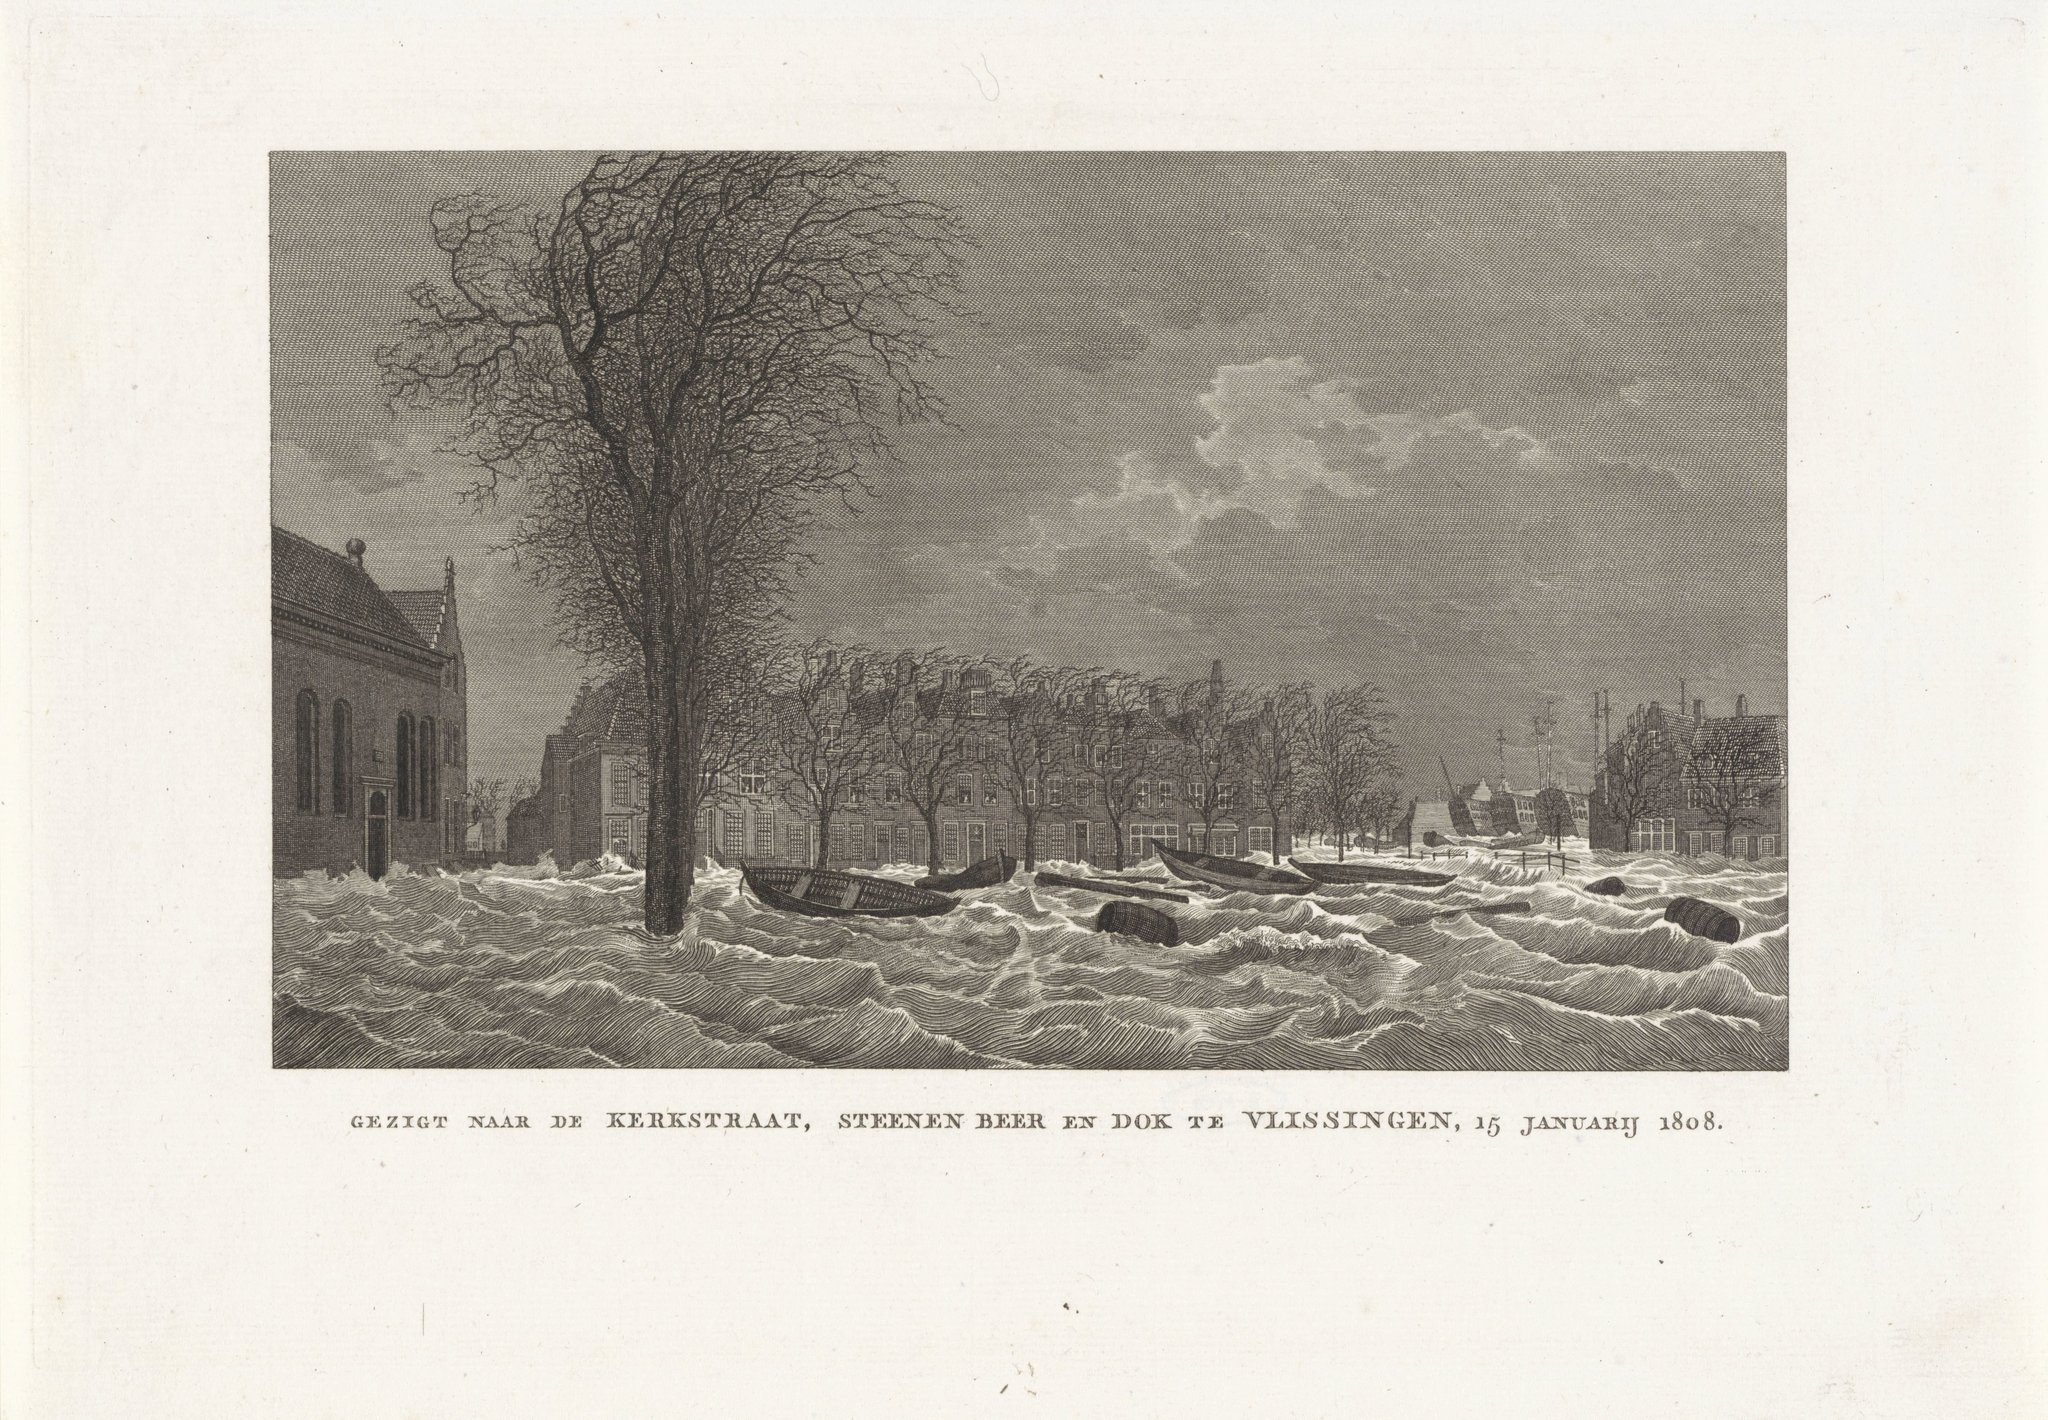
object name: print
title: Gezigt naar de Kerkstraat, Steenen Beer en Dok te Vlissingen, 15 januarj 1808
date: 1808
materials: paper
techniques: etching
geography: haarlem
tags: flood, flushing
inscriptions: collector's mark: Lugt Lugt 2228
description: Prent gebruikt in: Hoek, S. van. Natuur- en geschiedkundige beschrijving van den verschrikkelijken watervloed tusschen den XIVden en XVden van Louwmaand des jaars 1808. Haarlem: Adriaan Pietersz. Loosjes, 1808.